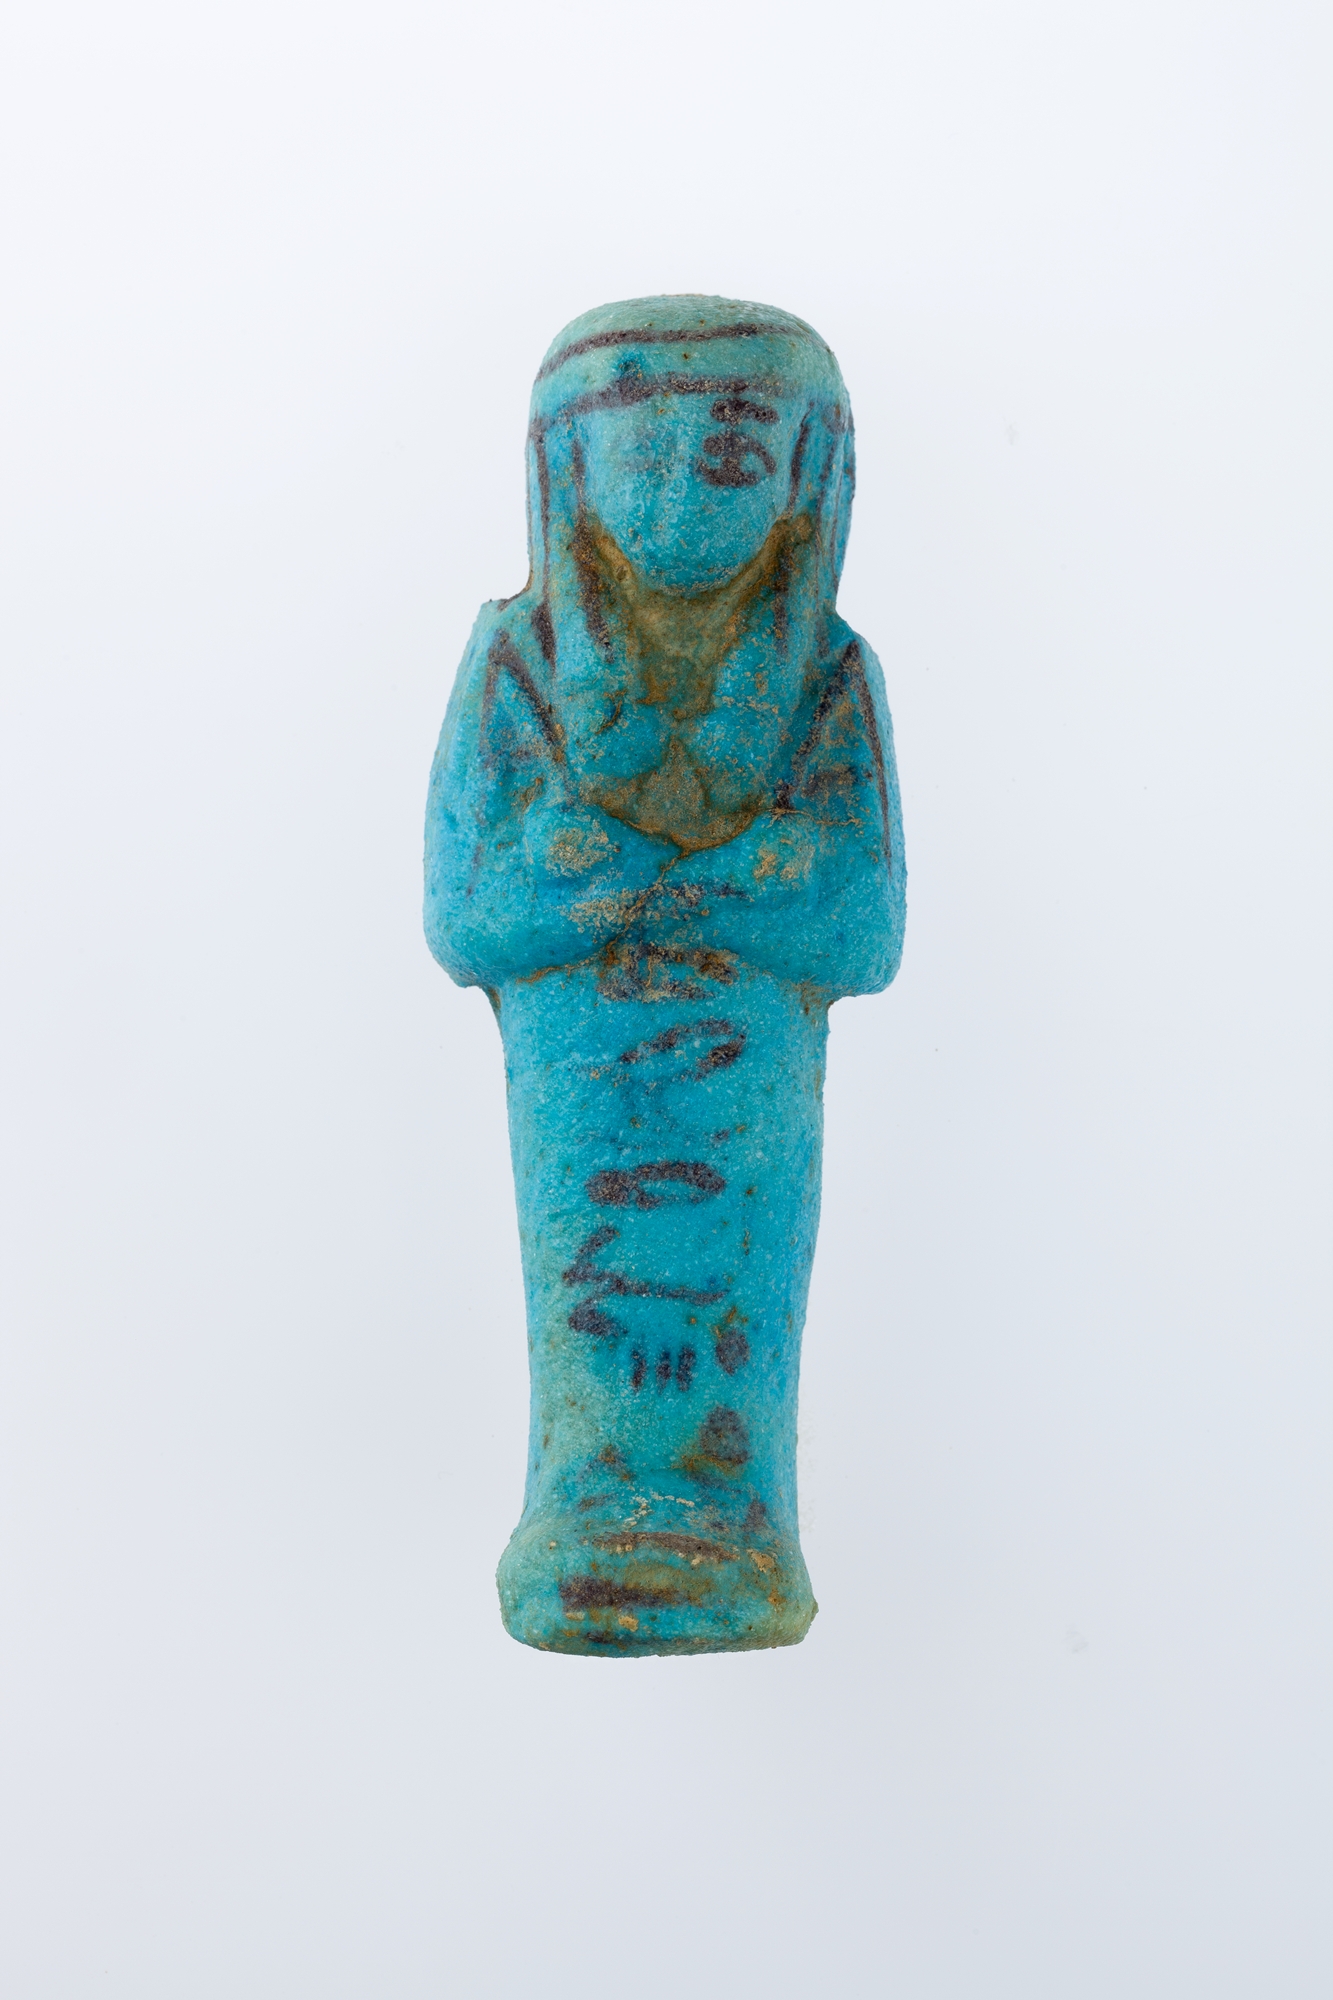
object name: shabti, henettawy c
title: Worker Shabti of Henettawy (C), Daughter of Isetemkheb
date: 990-970 BCE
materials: faience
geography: egypt